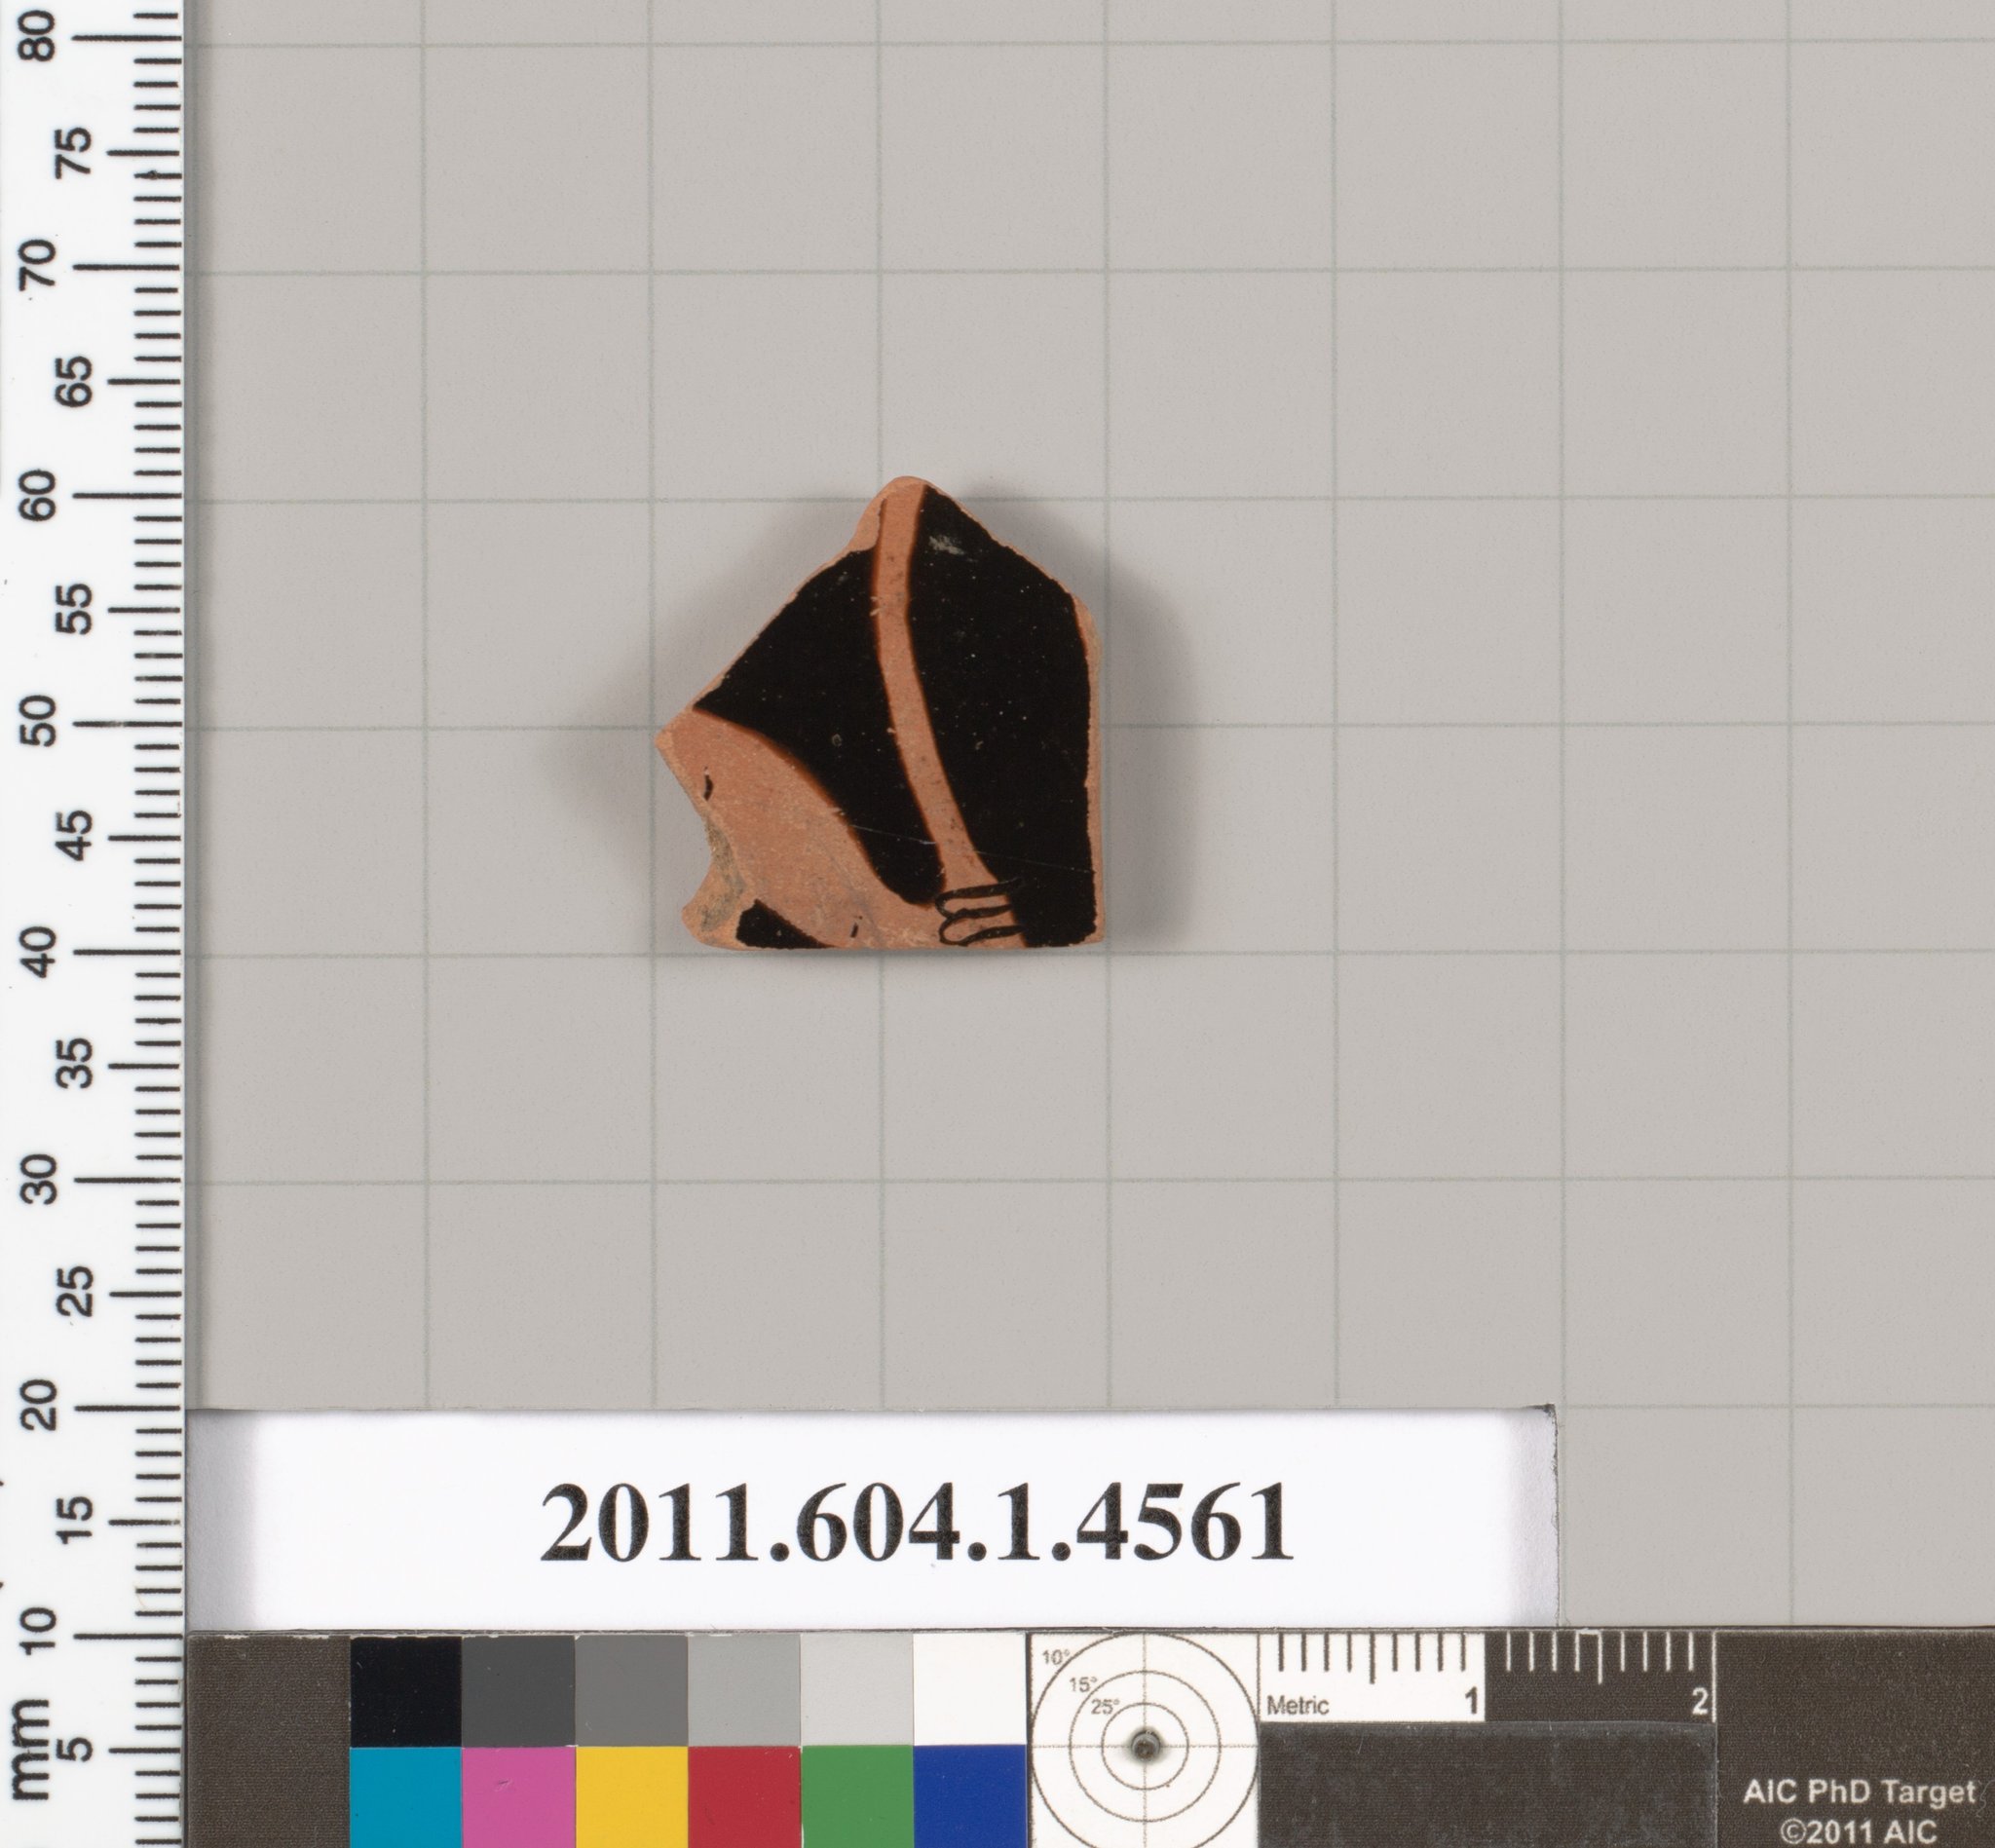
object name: kylix fragment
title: Terracotta fragment of a kylix (drinking cup)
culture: greek, attic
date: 475-451 BCE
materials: terracotta